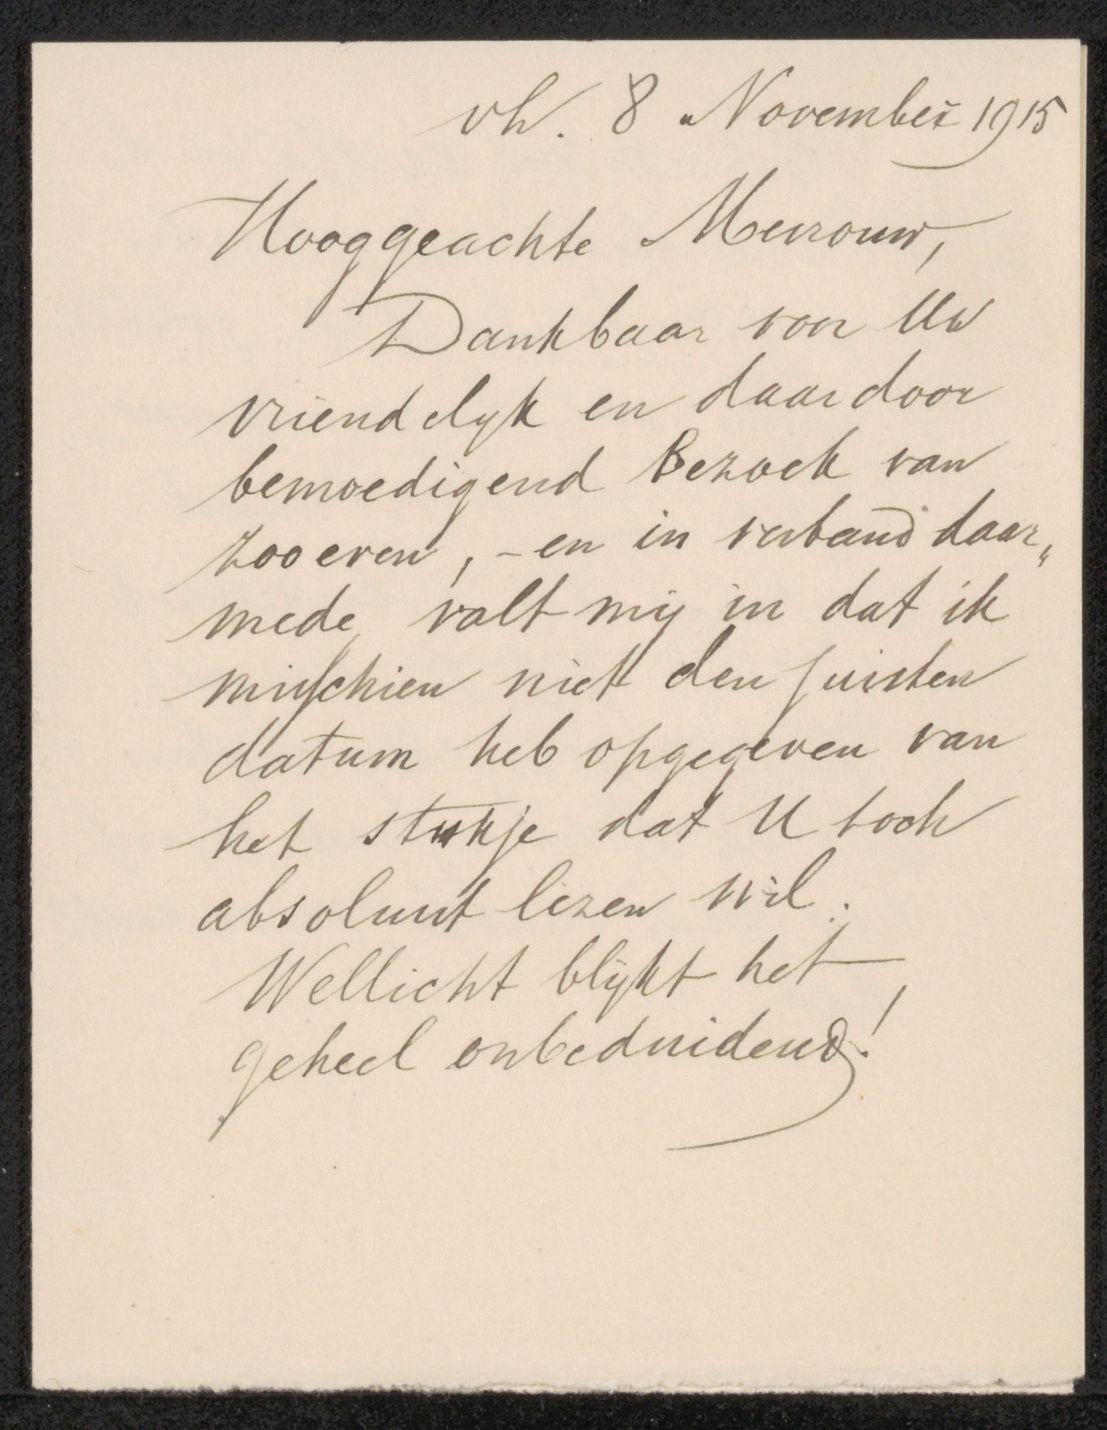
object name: letter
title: Brief aan Anne Antoinette Weber-Van Bosse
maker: august allebé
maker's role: draughtsman, print maker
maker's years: 1838-1927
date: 1915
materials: ink, paper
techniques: pen, writing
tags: anne antoinette weber-van bosse, louis bertrand